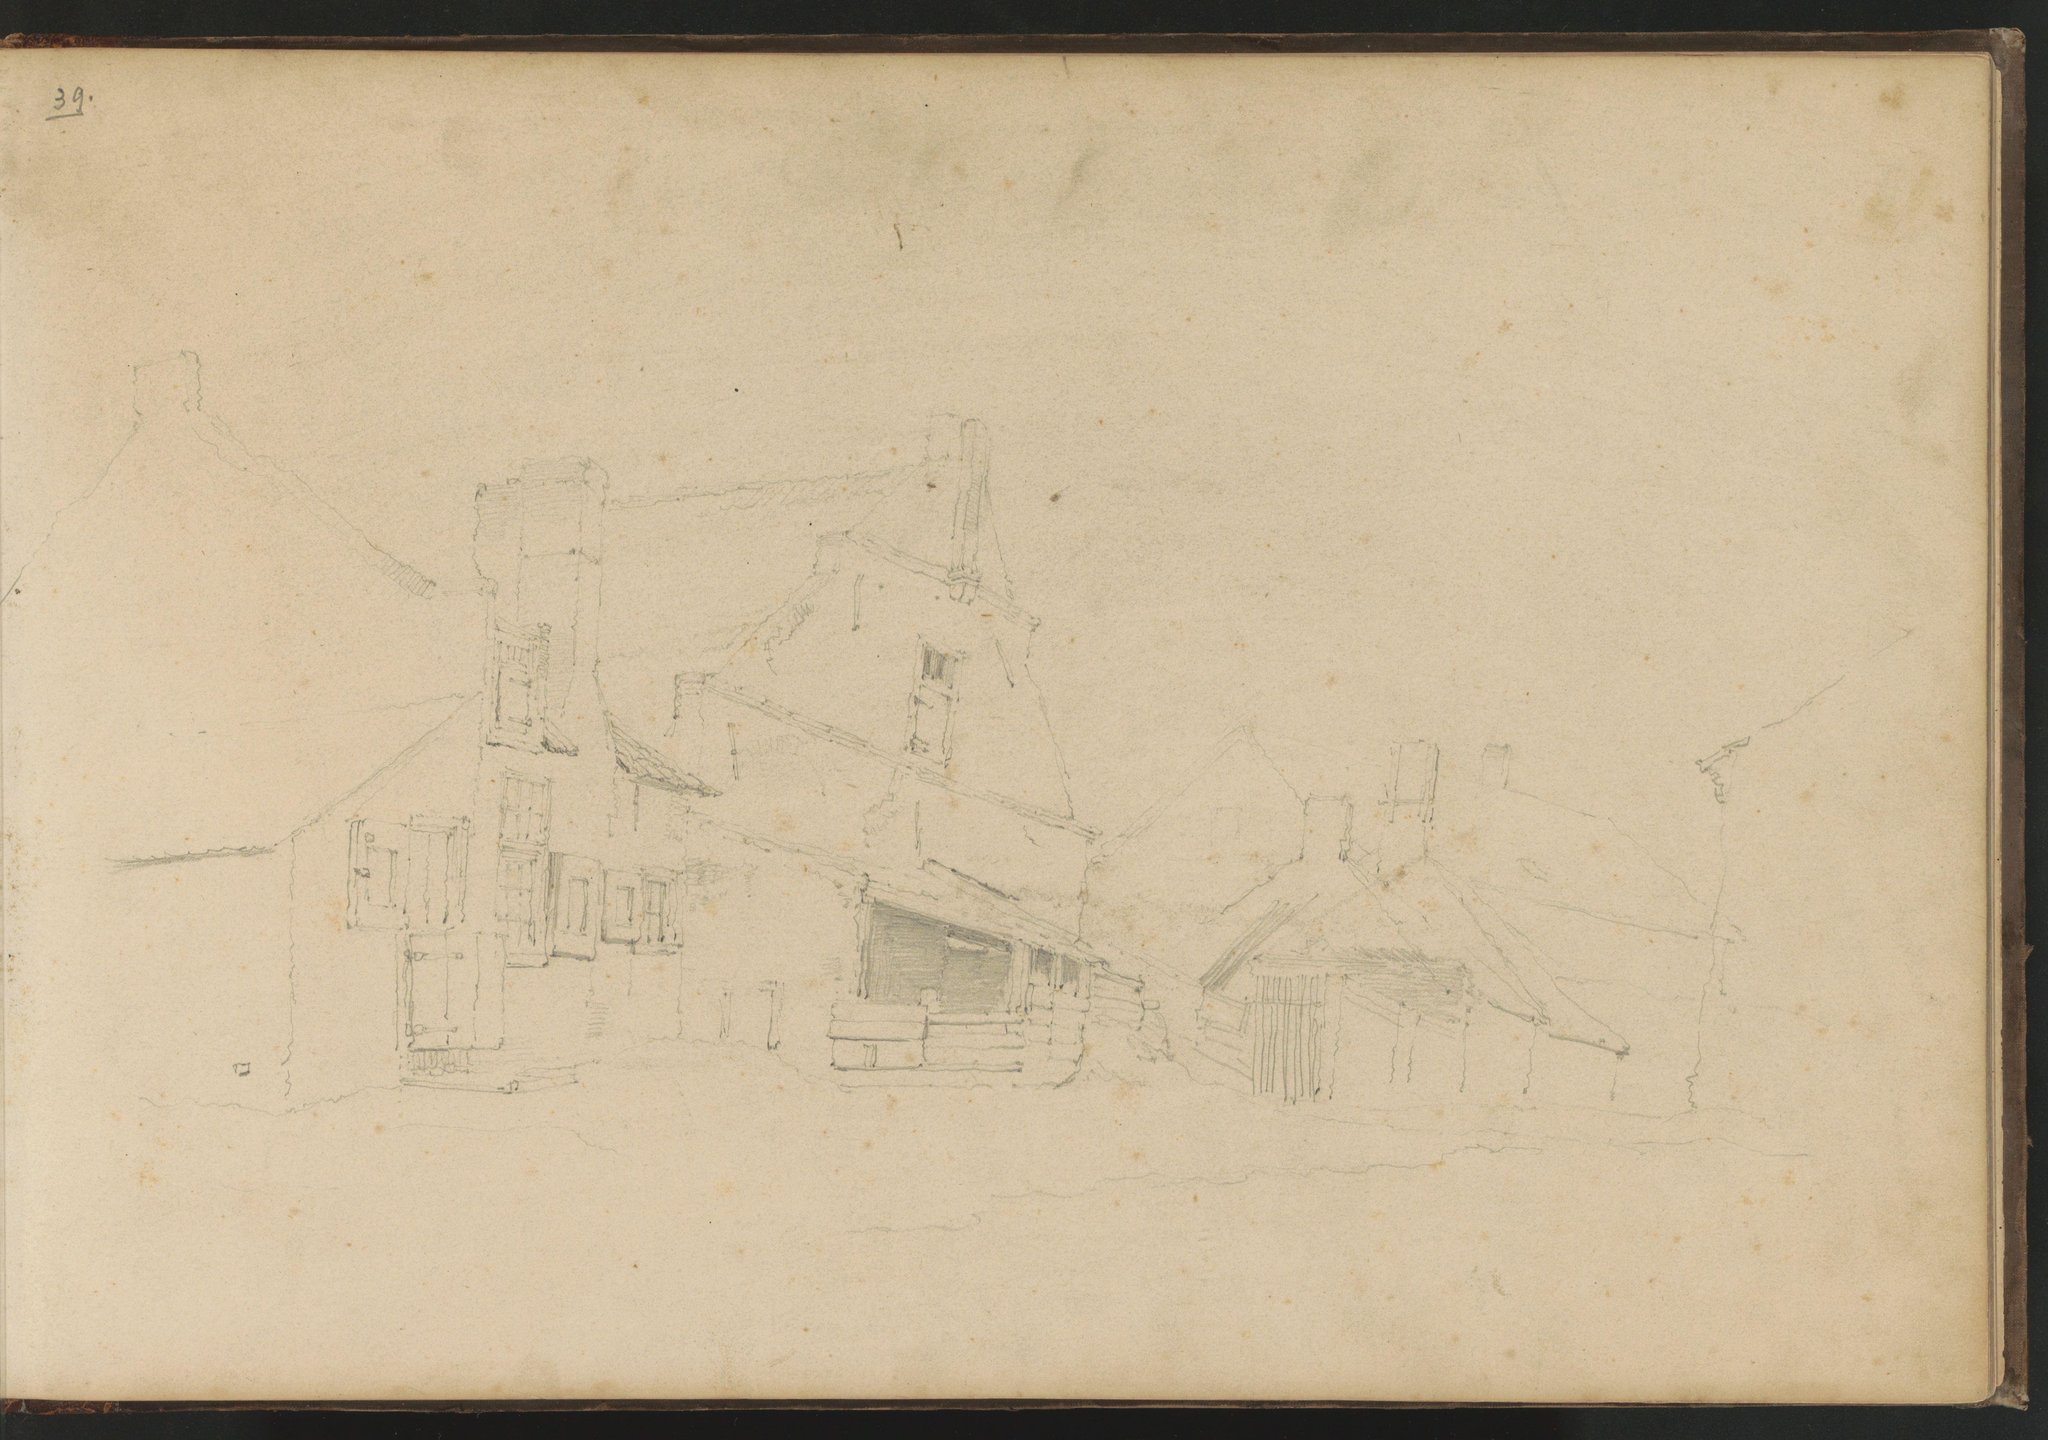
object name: sketchbook leaf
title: Dorpsstraat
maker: kasparus karsen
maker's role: draughtsman, painter, print maker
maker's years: 1810-1896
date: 1820-1896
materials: paper, pencil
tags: village street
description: Blad 39 recto uit een schetsboek met 68 bladen.